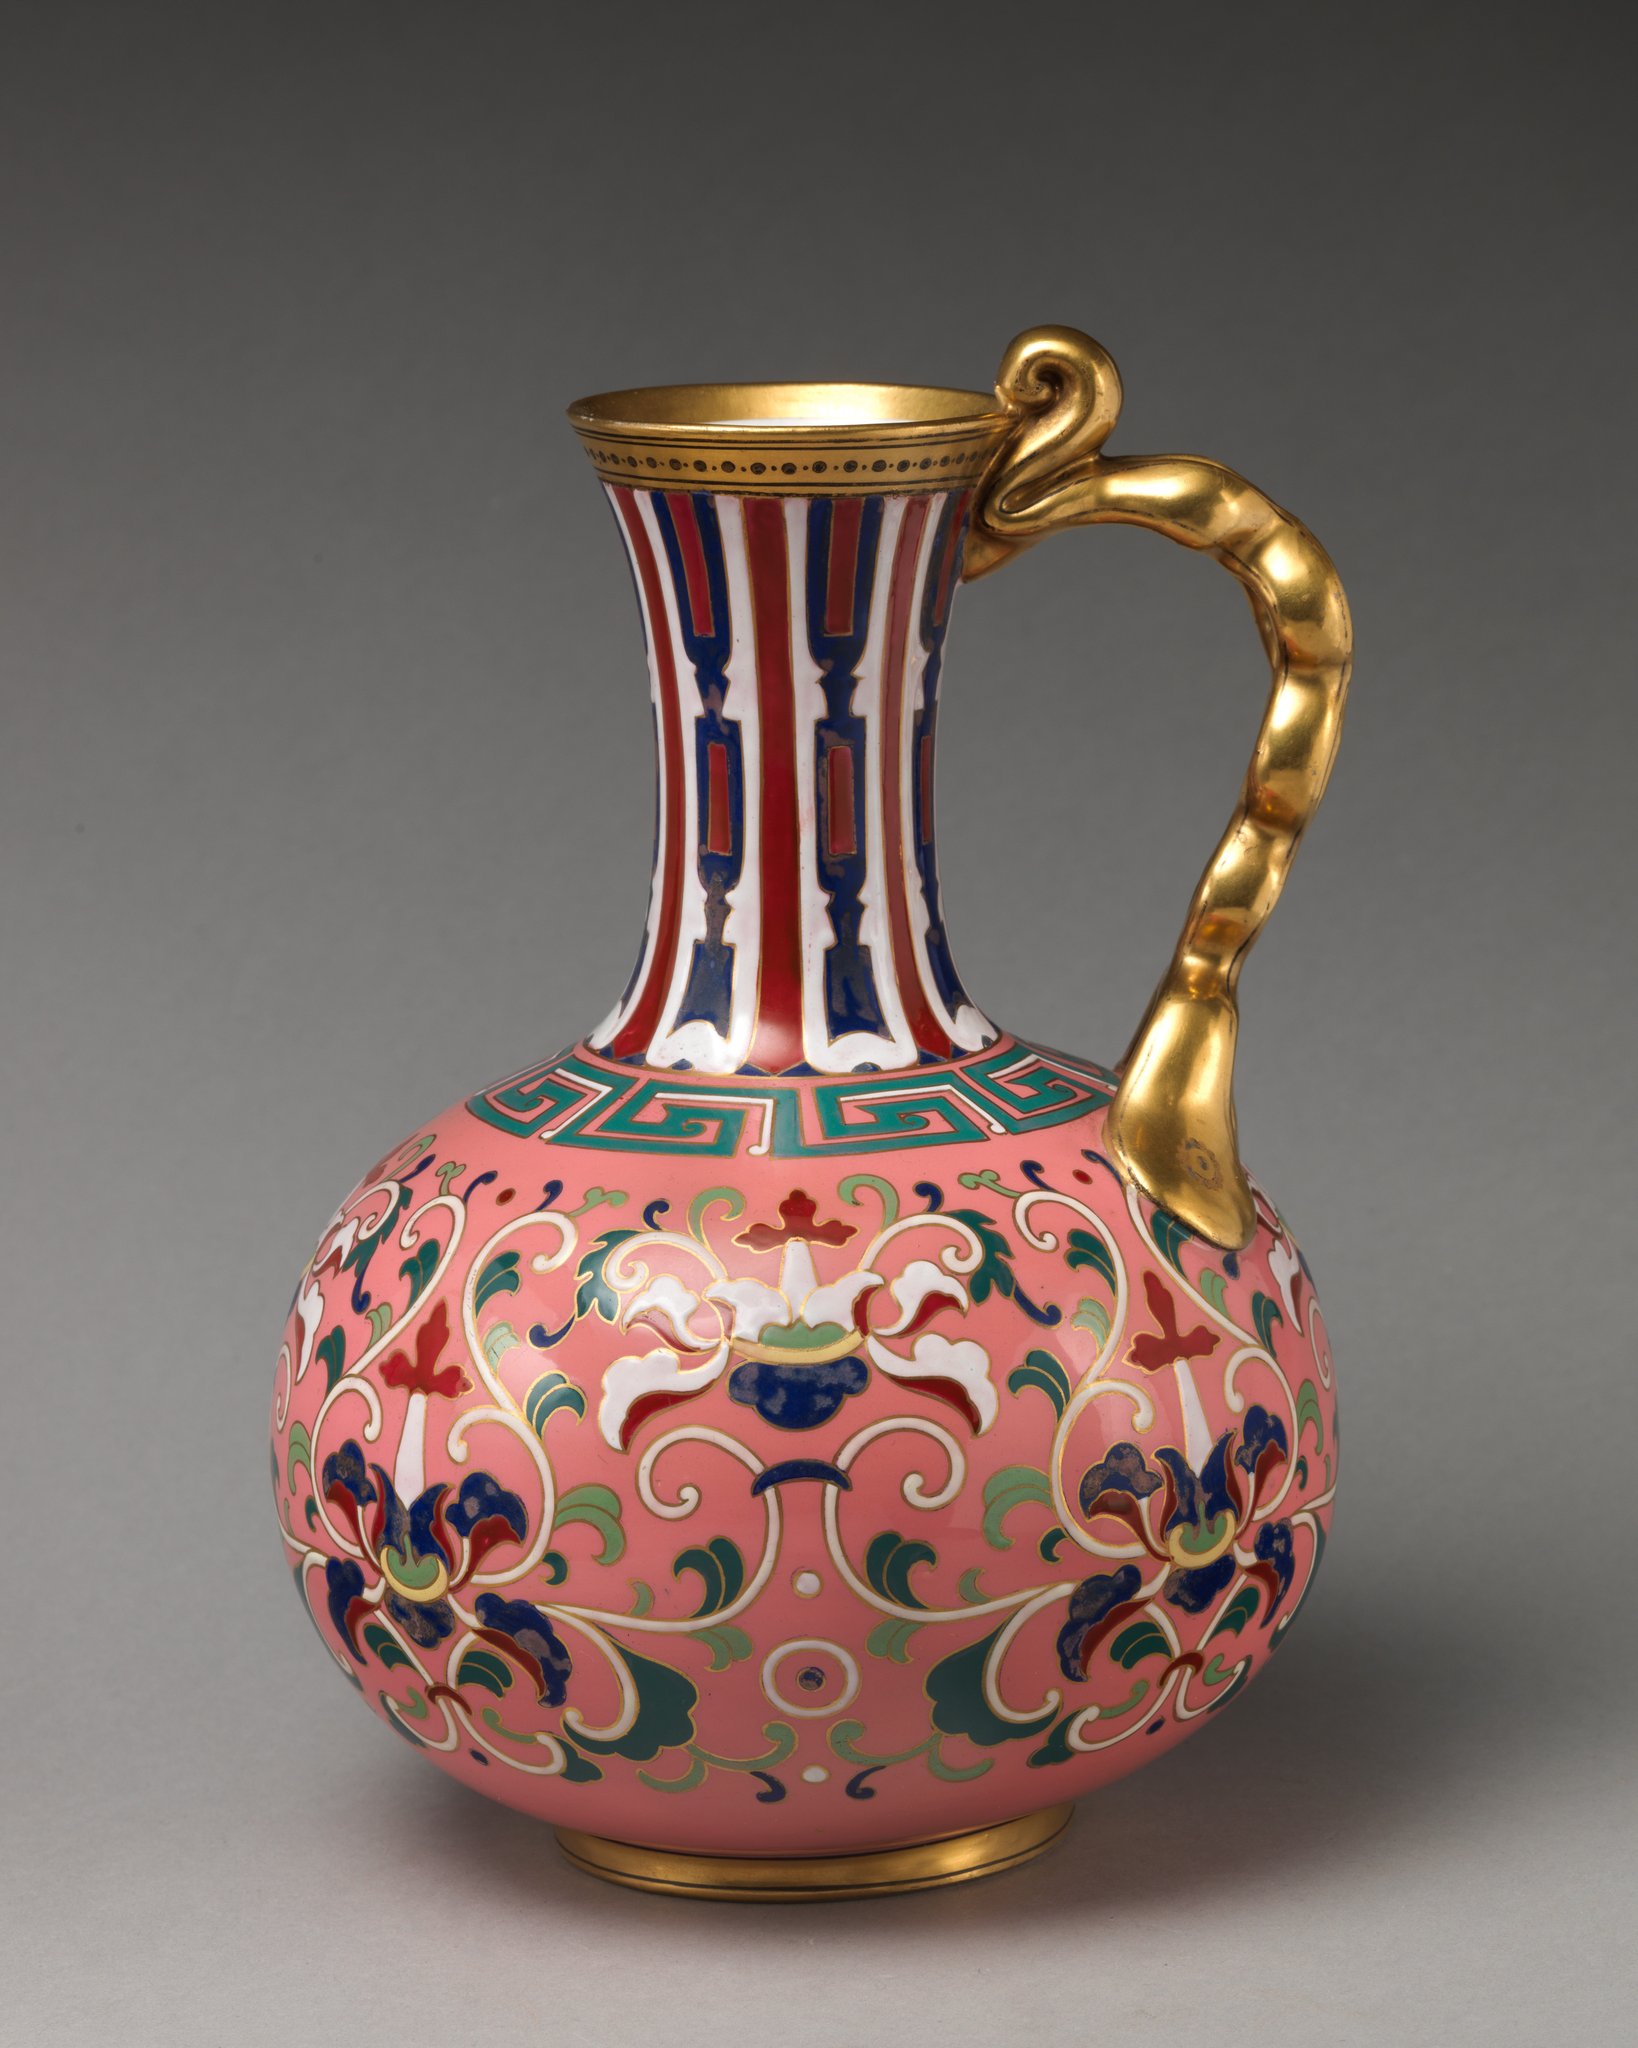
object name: ewer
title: Ewer with "cloisonné" decoration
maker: minton(s)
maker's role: maker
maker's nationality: british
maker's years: 1793-2001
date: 1873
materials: bone china, enamel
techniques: gilding